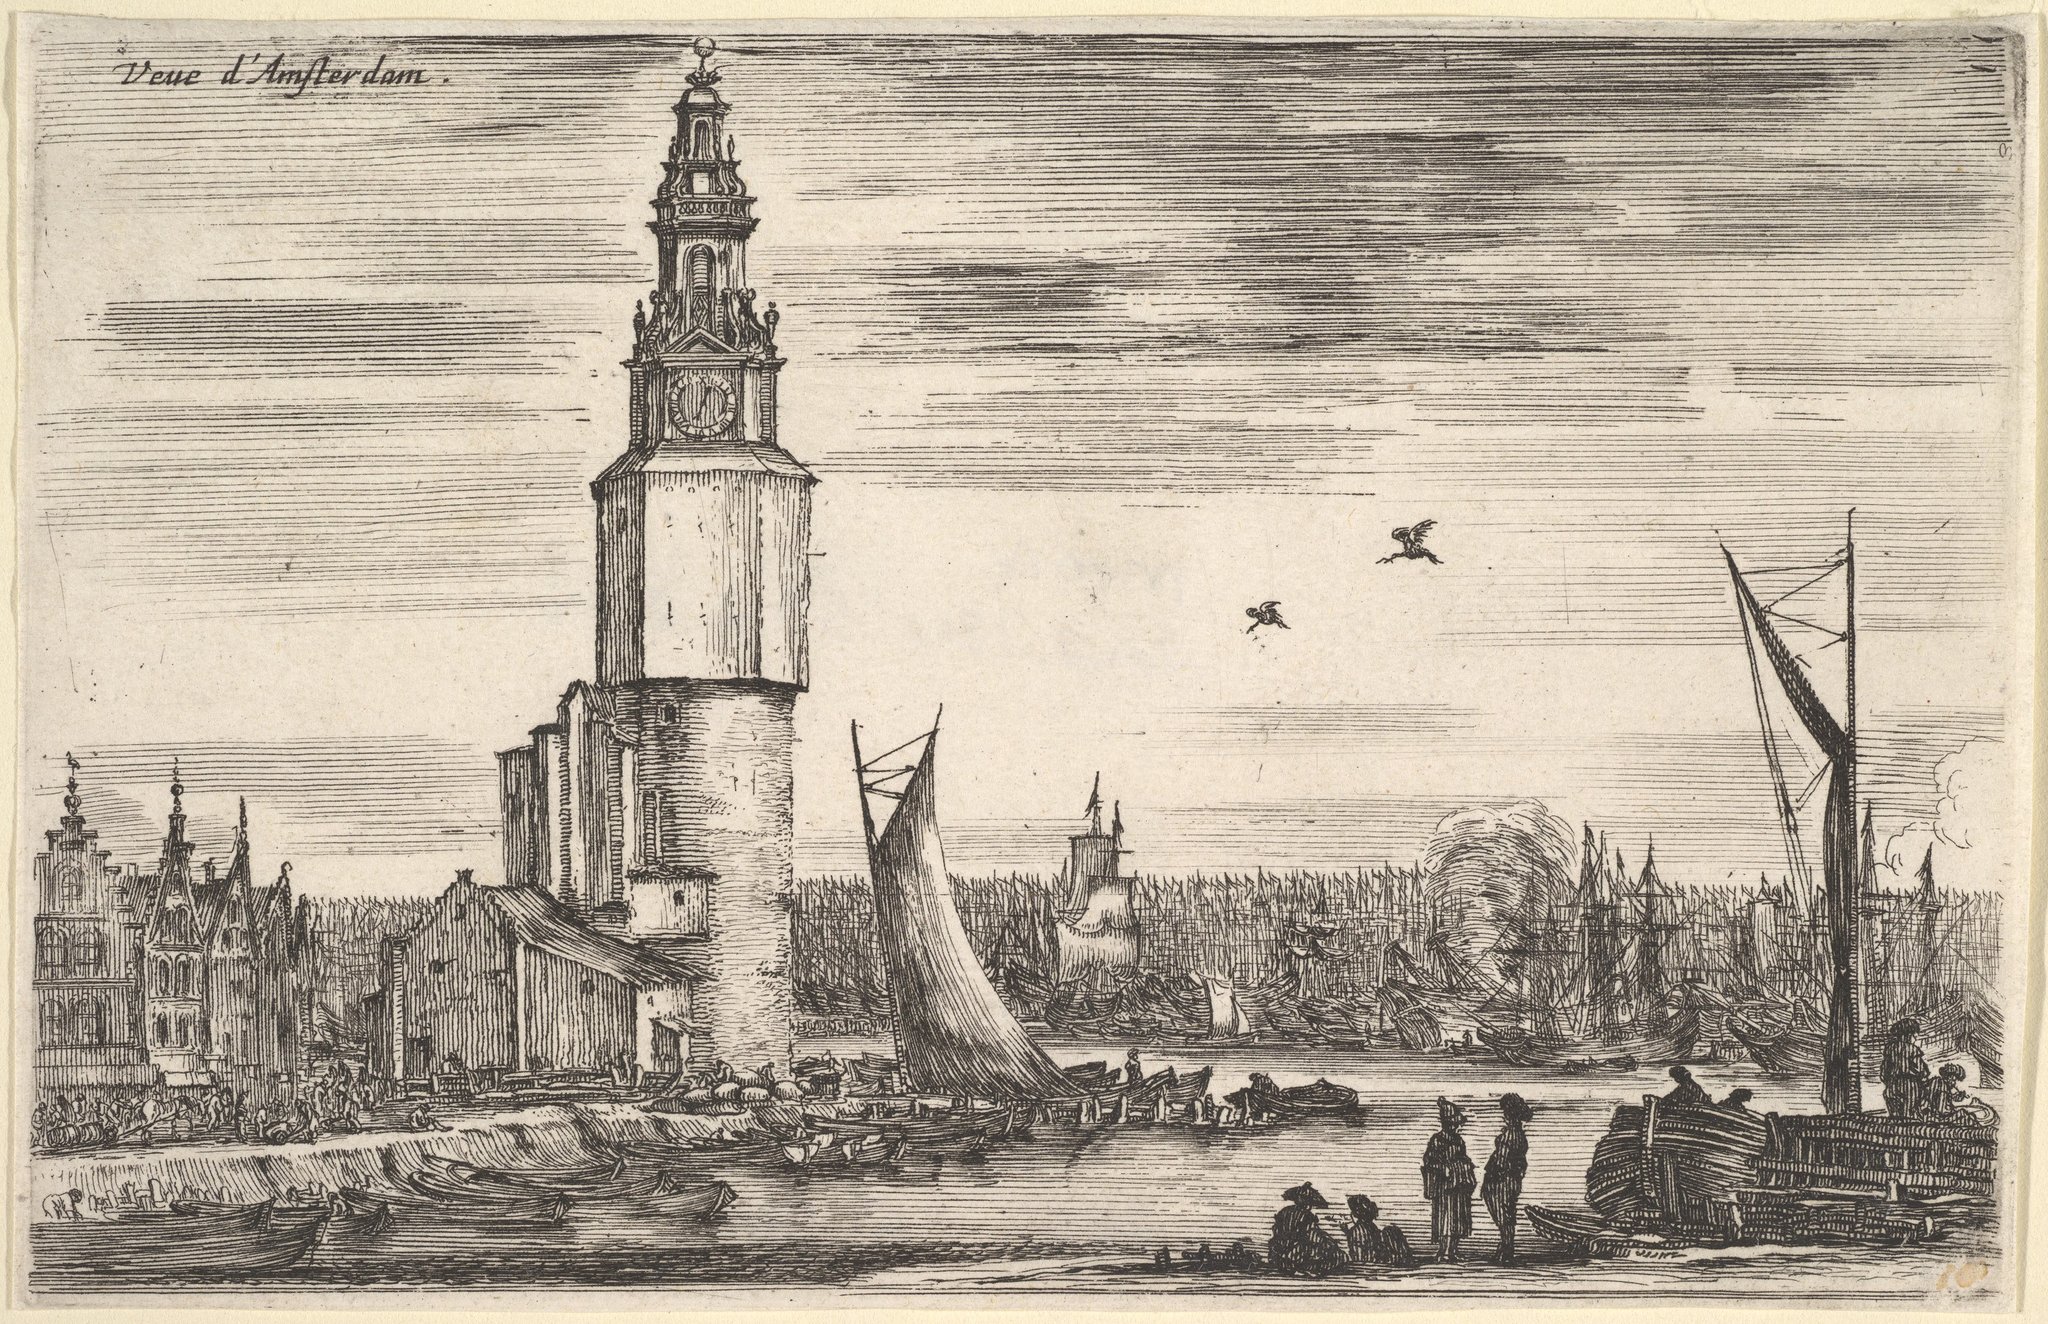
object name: print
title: View of Amsterdam (Vue d'Amsterdam), from "Views of seaports" (Vues de ports de mar)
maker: stefano della bella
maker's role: artist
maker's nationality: italian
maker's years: 1610-1664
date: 1647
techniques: etching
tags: towers,cities,ships,amsterdam